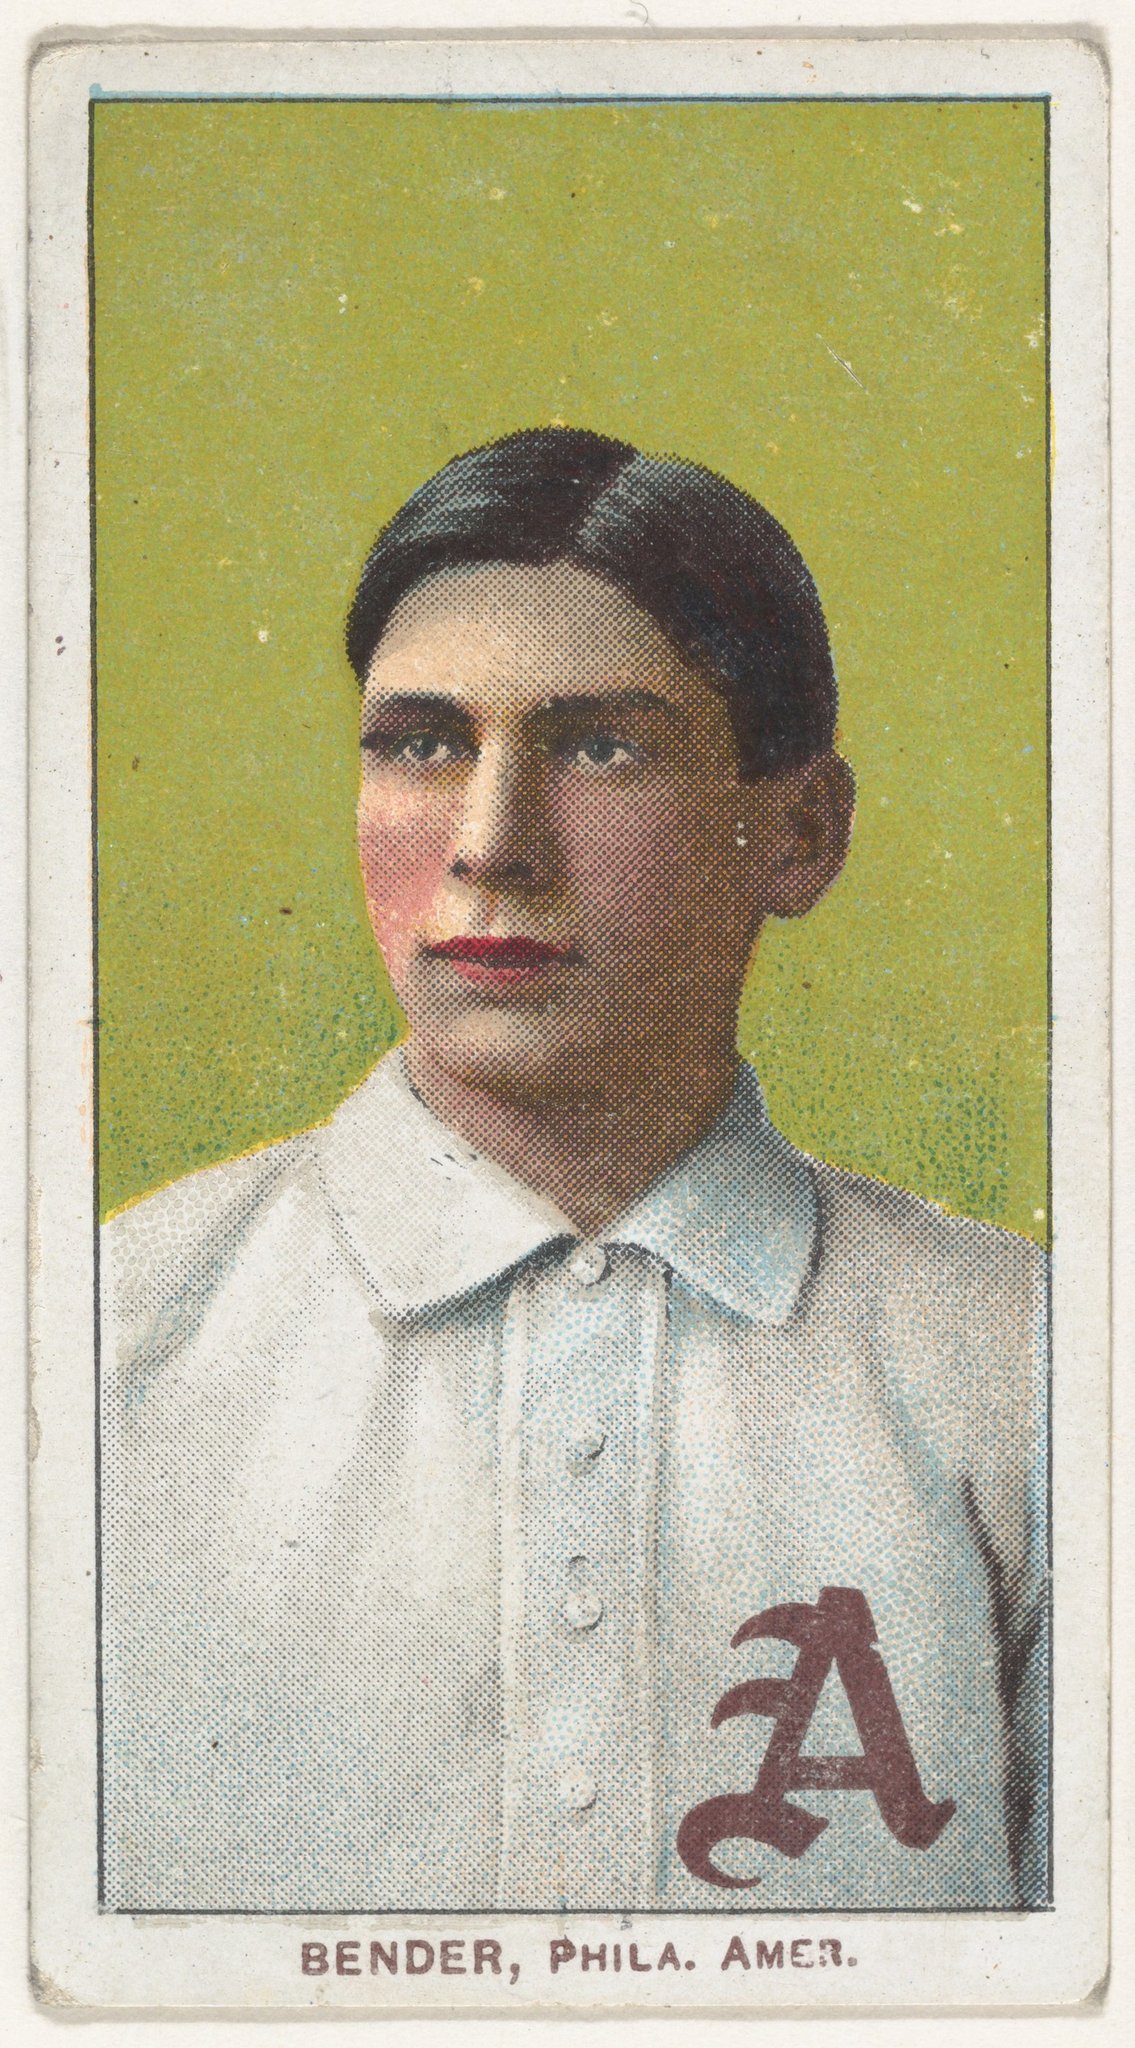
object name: baseball card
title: Bender, Philadelphia, American League, from the White Border series (T206) for the American Tobacco Company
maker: american tobacco company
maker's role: publisher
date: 1909-1911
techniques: color lithograph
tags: men,portraits,baseball,athletes